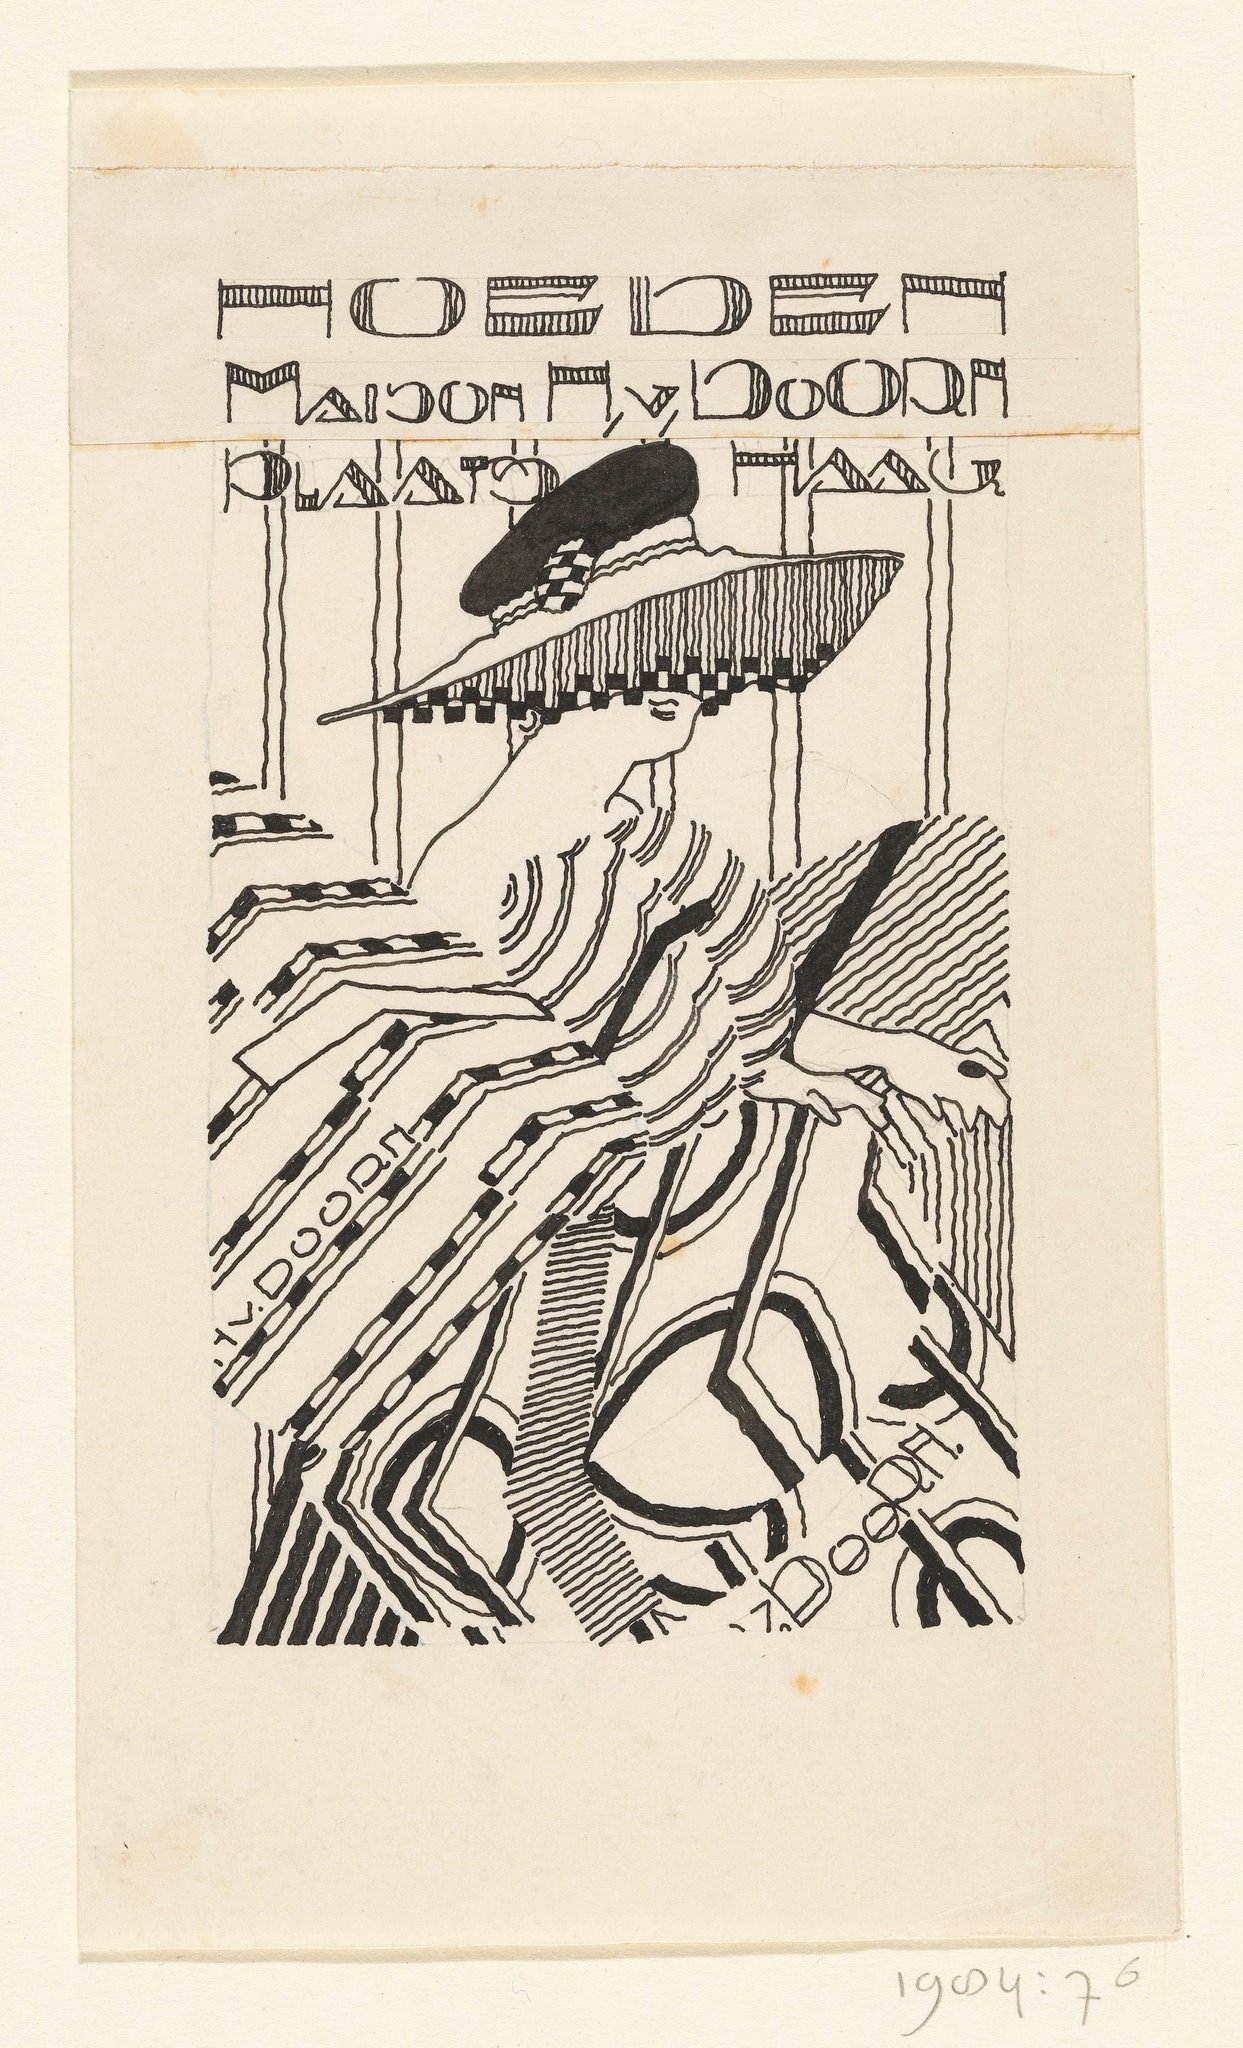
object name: drawing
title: Hoeden maison H. v. Doorn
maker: reijer stolk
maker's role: draughtsman, print maker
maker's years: 1896-1945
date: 1906-1945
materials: ink, paper, pencil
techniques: brush, pen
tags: names of organizations, companies, trade unions, etc., head-gear: hat (+ men's clothes), advertisement, notice, the hague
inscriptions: collector's mark: Lugt 2760, collector's mark: Lugt 2228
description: Deze tekening is mogelijk een ontwerp voor een advertentie.